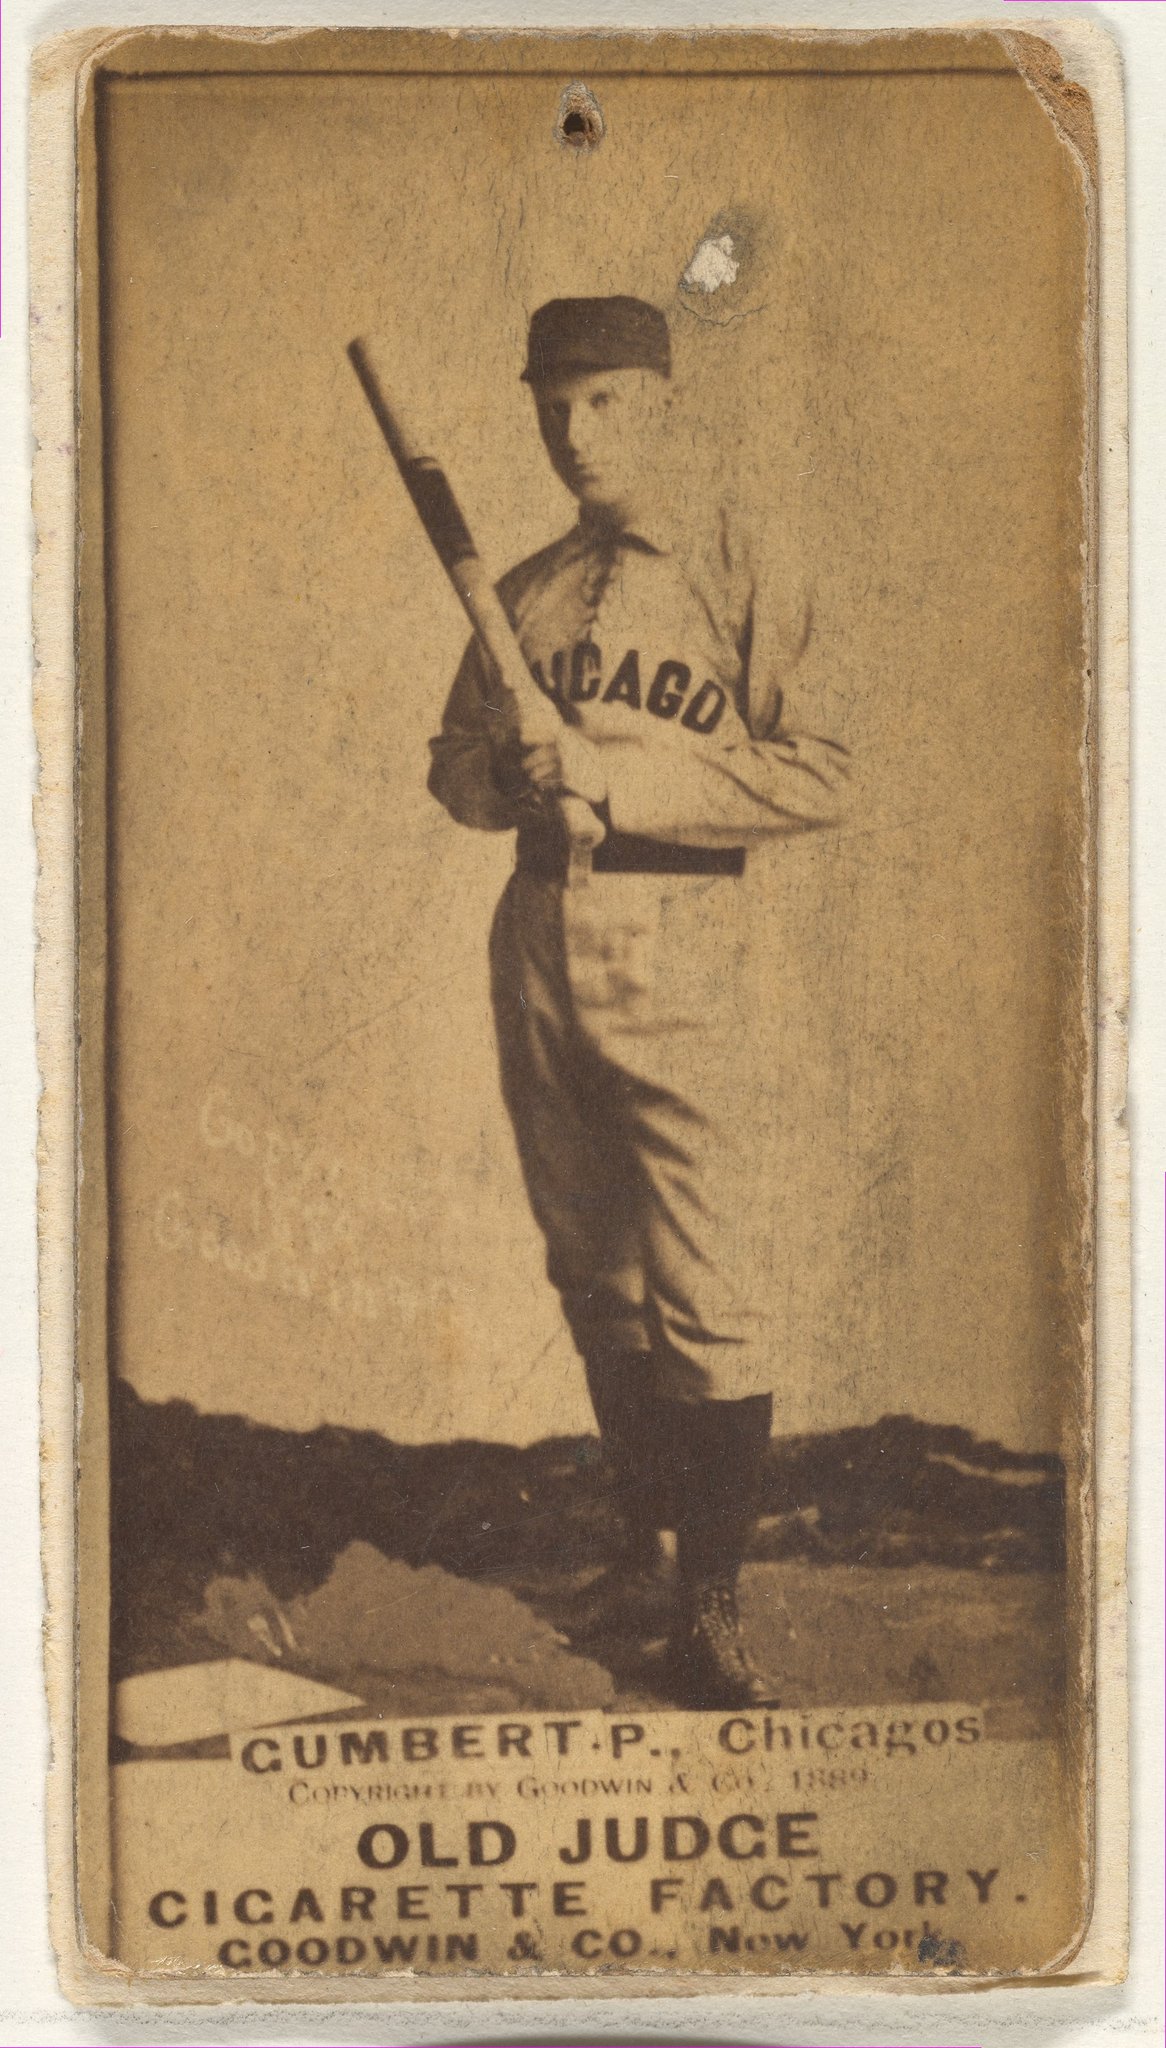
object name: baseball card, photograph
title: Gumbert, Pitcher, Chicago, from the Old Judge series (N172) for Old Judge Cigarettes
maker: goodwin & company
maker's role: publisher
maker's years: 1850-1950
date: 1889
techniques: albumen silver print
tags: men,portraits,baseball,athletes